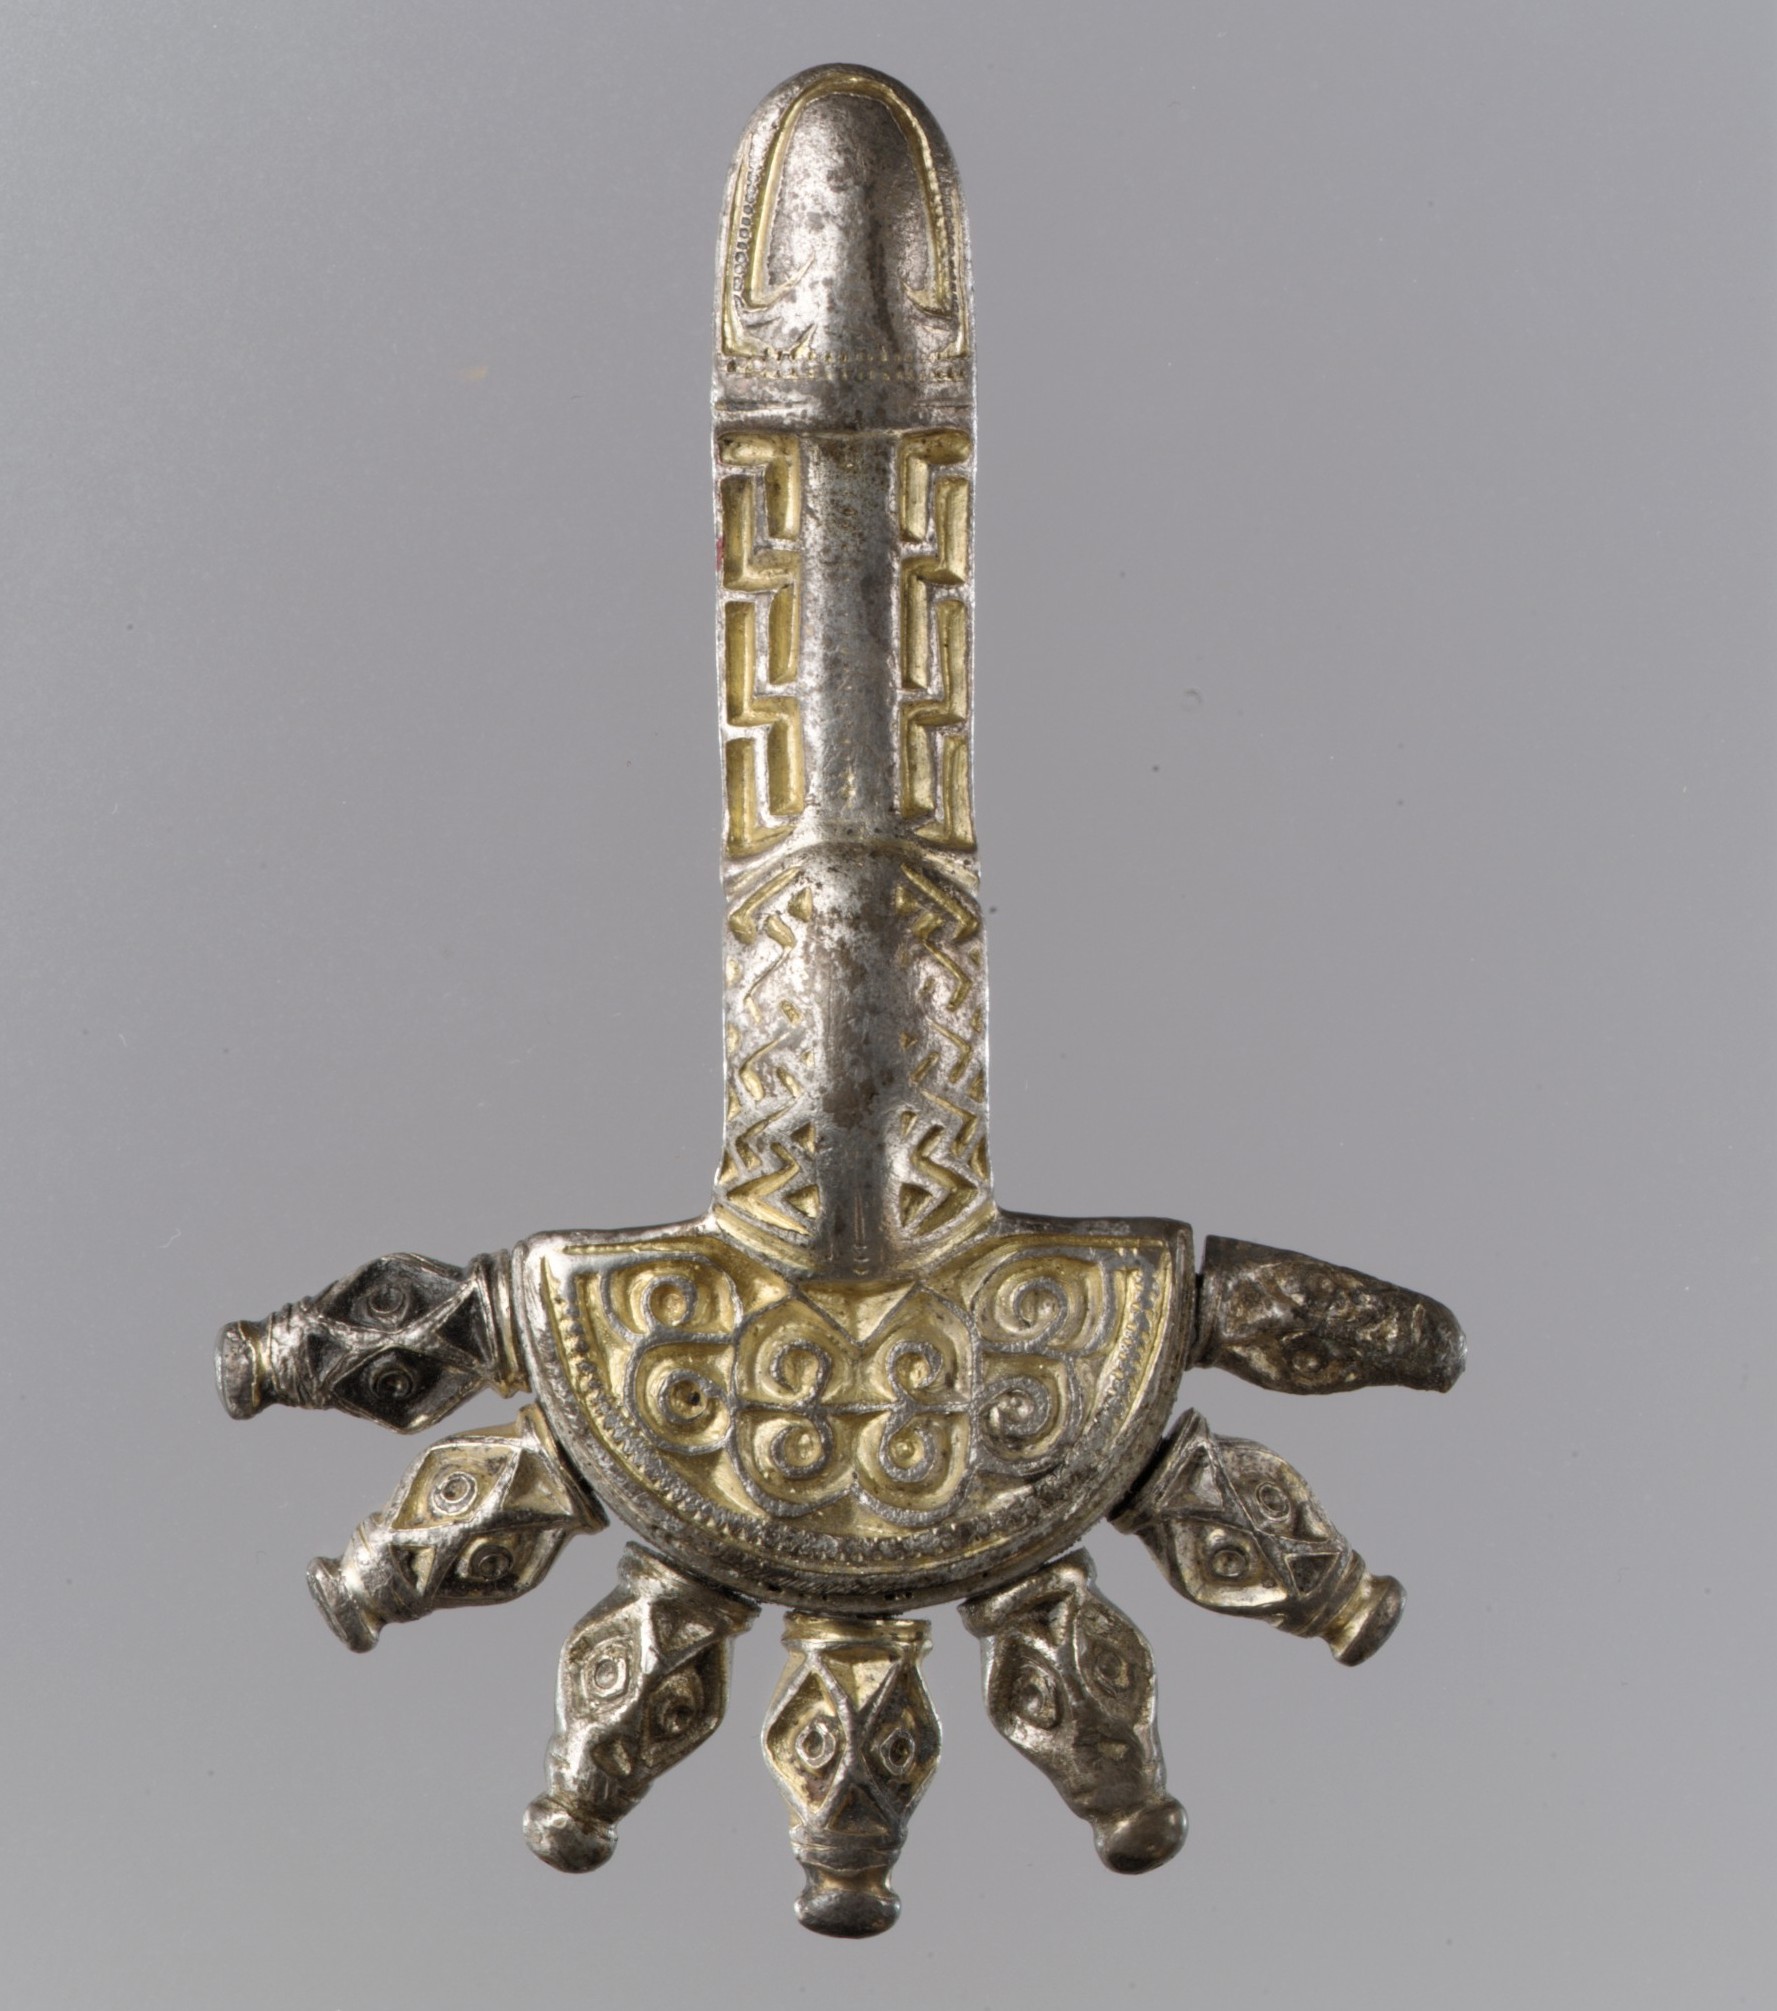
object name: brooch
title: Bow Brooch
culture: alemannic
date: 467-533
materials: silver gilt